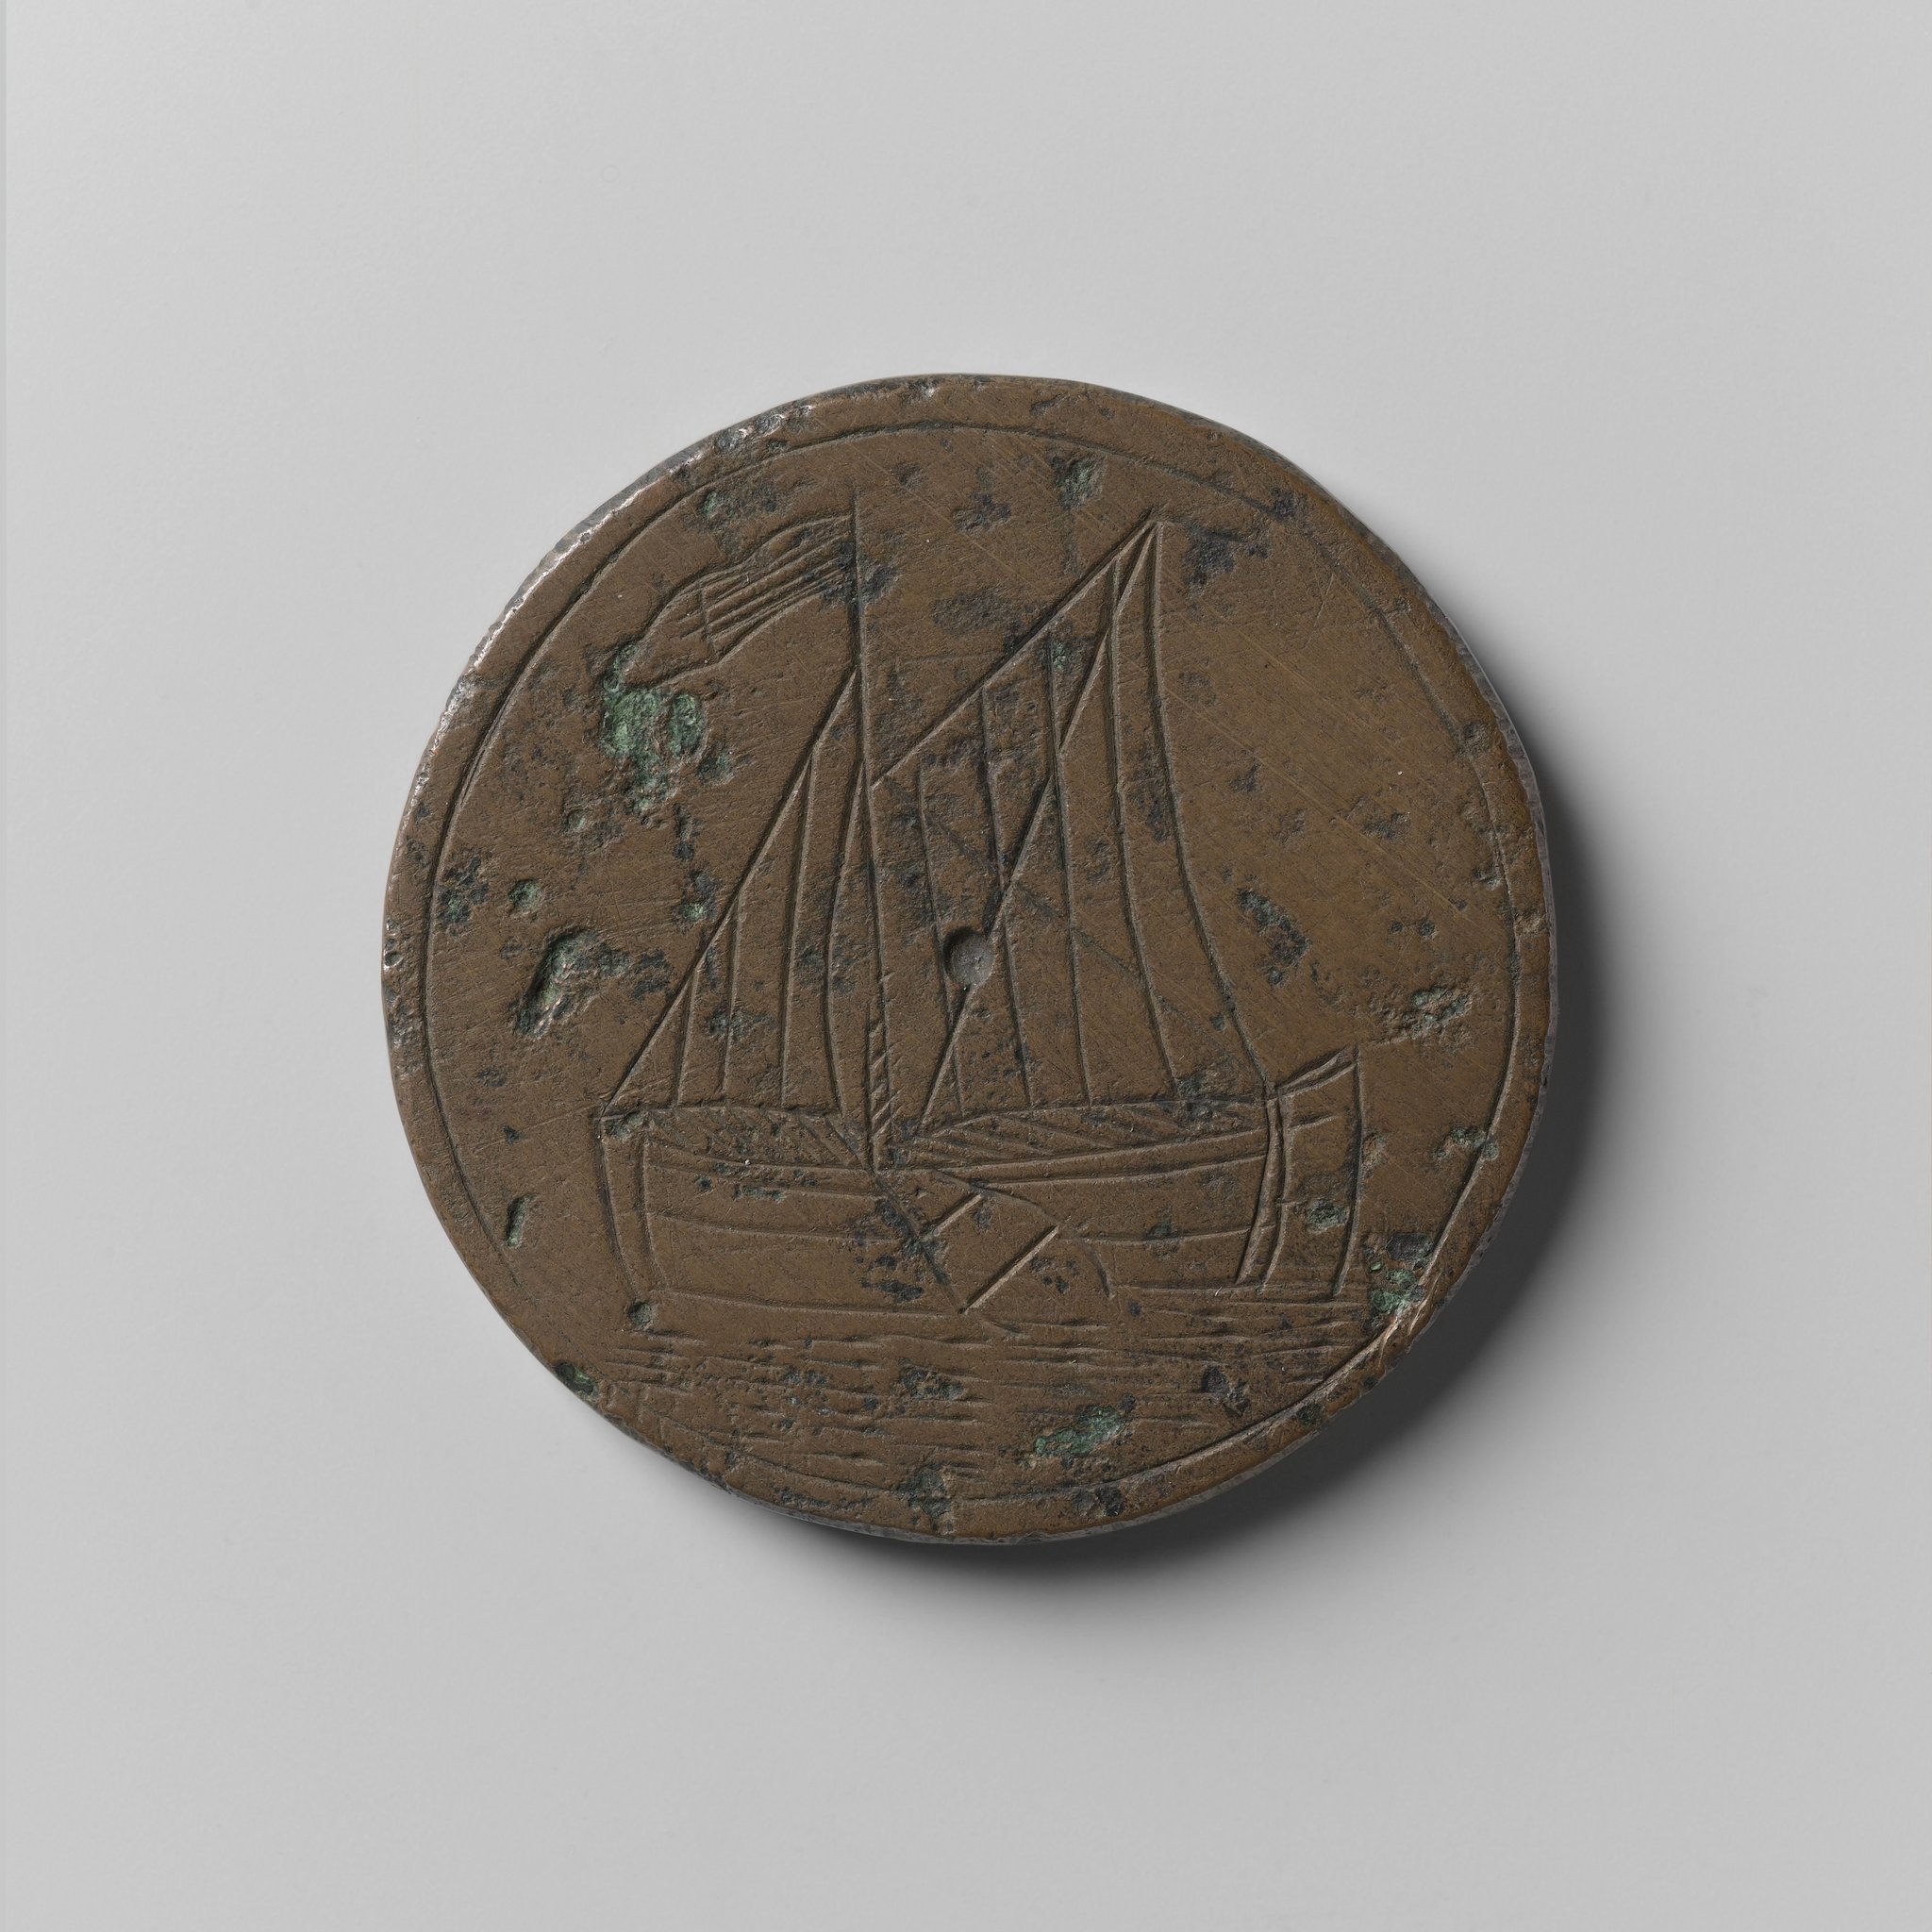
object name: medal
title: Schippersgilde, gildepenning van Gerret Vermeer van Harderwijk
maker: Anonymous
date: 1762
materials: copper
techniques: engraving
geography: netherlands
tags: amsterdam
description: Koperen penning. Voorzijde: naar links varend schip binnen omschrift. Keerzijde: opschrift.